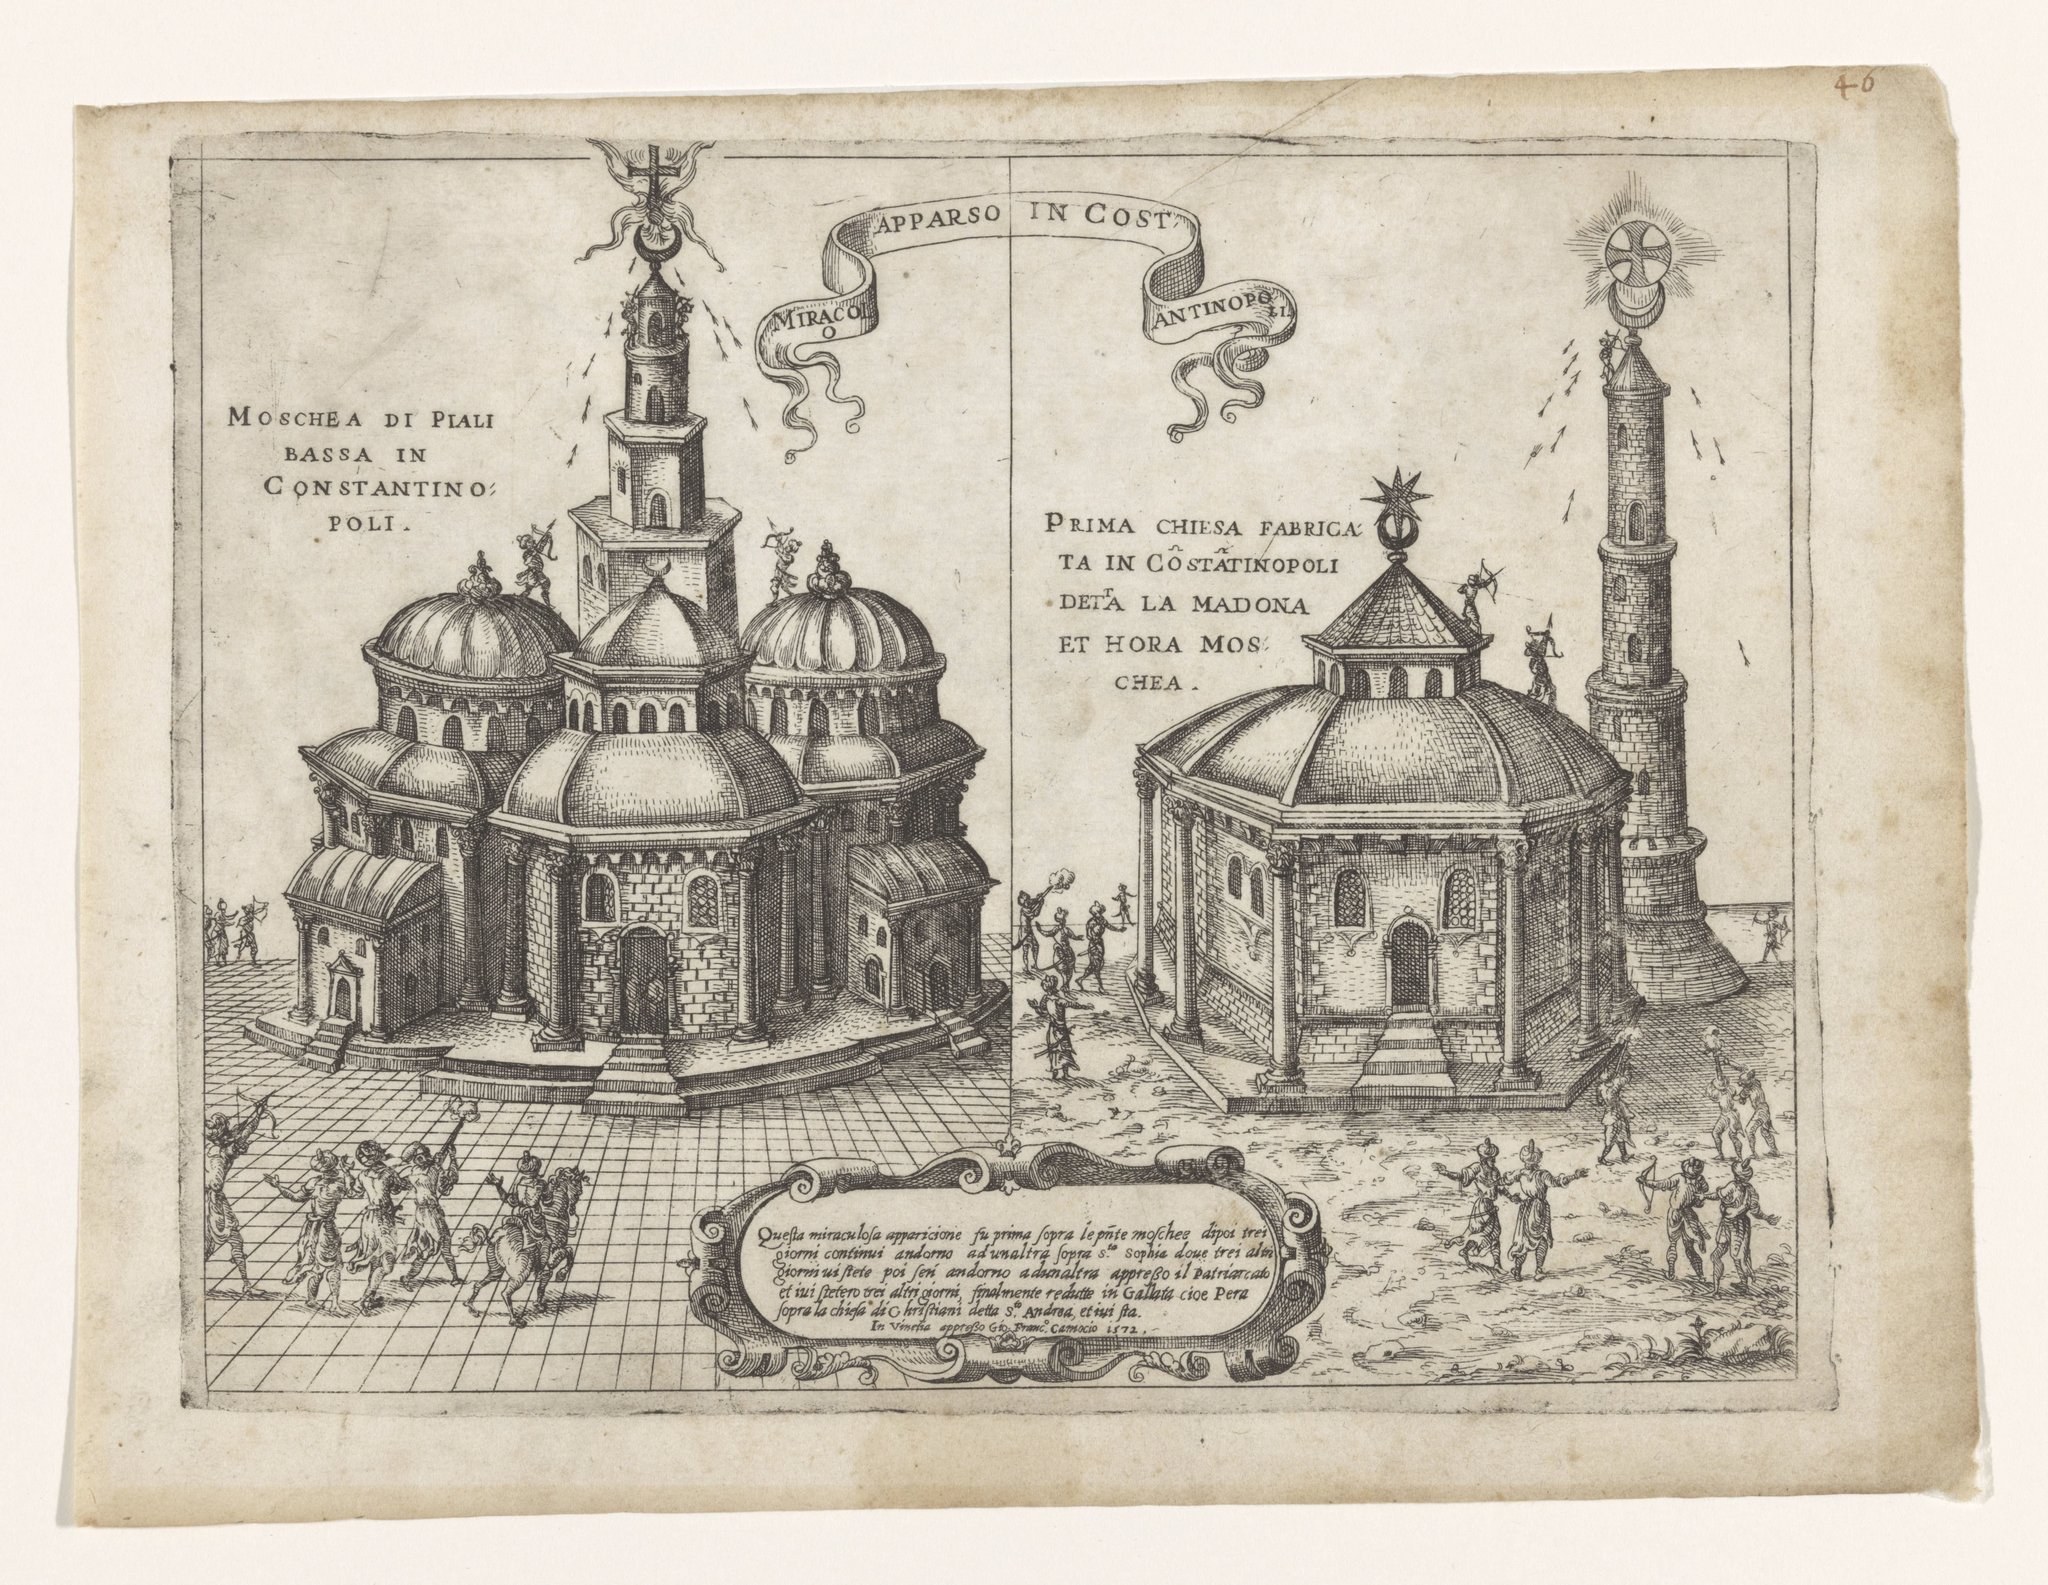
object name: print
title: Christelijk wonder voorgevallen in Constantinopel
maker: giovanni francesco camocio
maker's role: print maker, publisher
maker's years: 1501-1575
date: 1572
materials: paper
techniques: etching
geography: venice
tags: temple, shrine ~ islam, mohammedanism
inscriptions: collector's mark: Lugt 2228, collector's mark: Lugt 2760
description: Wonder voorgevallen in Constantinopel ca. 1572 waarbij een christelijk kruis verscheen bovenop de halve maan aan de top van een minaret van een moskee. Turkse soldaten schieten met pijlen naar de kruisen. Onderaan een cartouche met een tekst in het Italiaans.